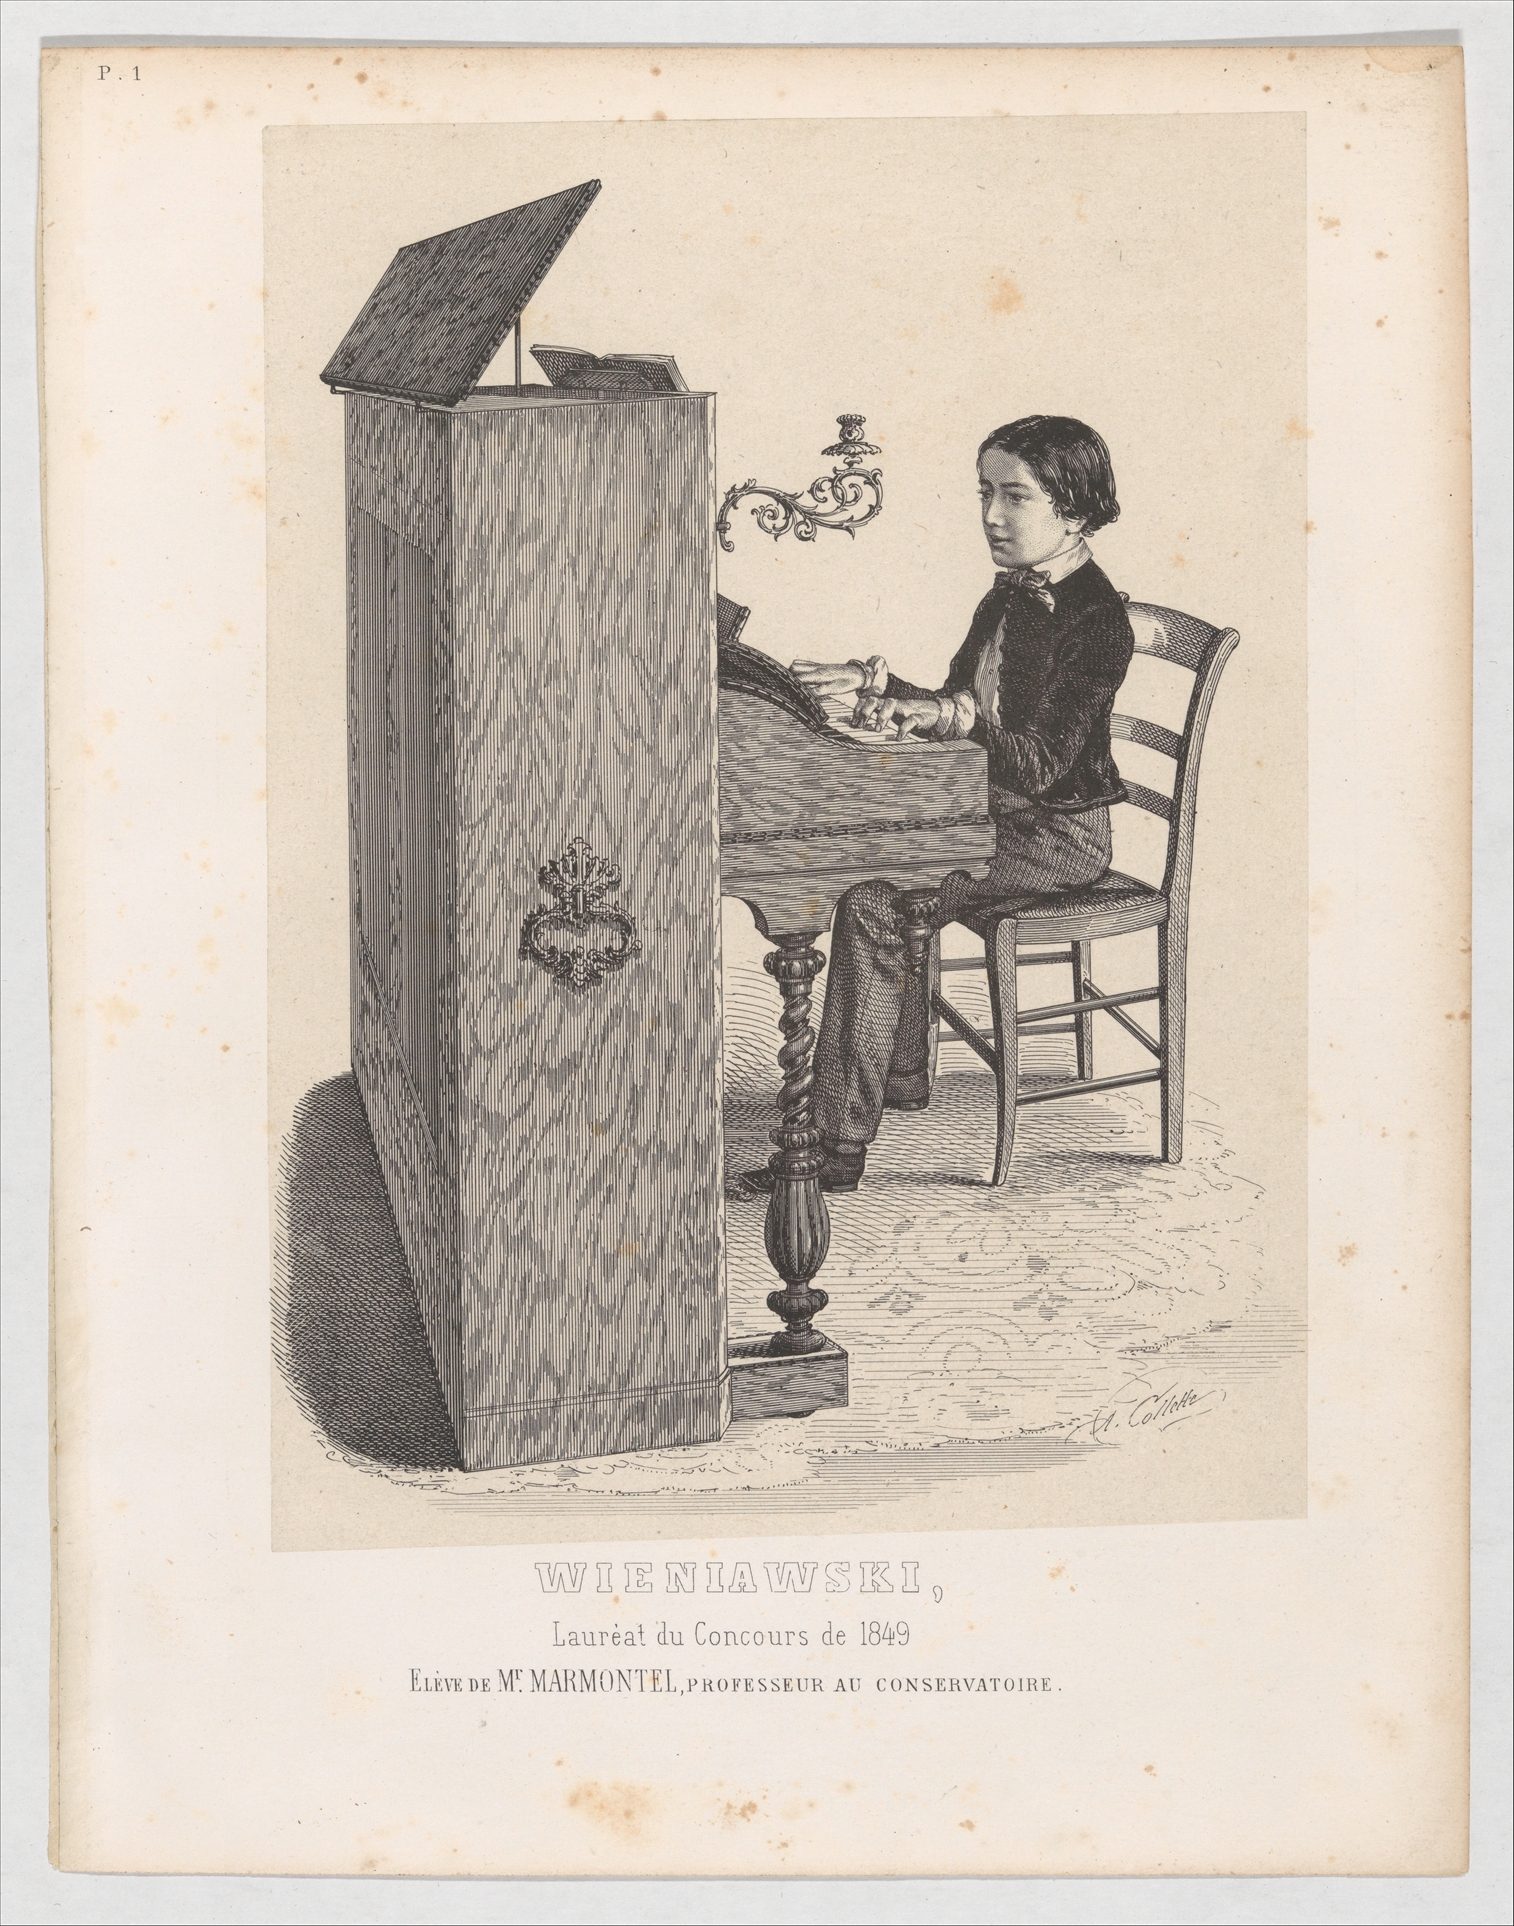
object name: lithographic plate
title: Lithographic Plates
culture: french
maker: alexandre désiré collette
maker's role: print maker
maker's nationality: french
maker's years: 1814-1876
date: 1850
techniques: lithograph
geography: france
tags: musical instruments,men,women,musicians